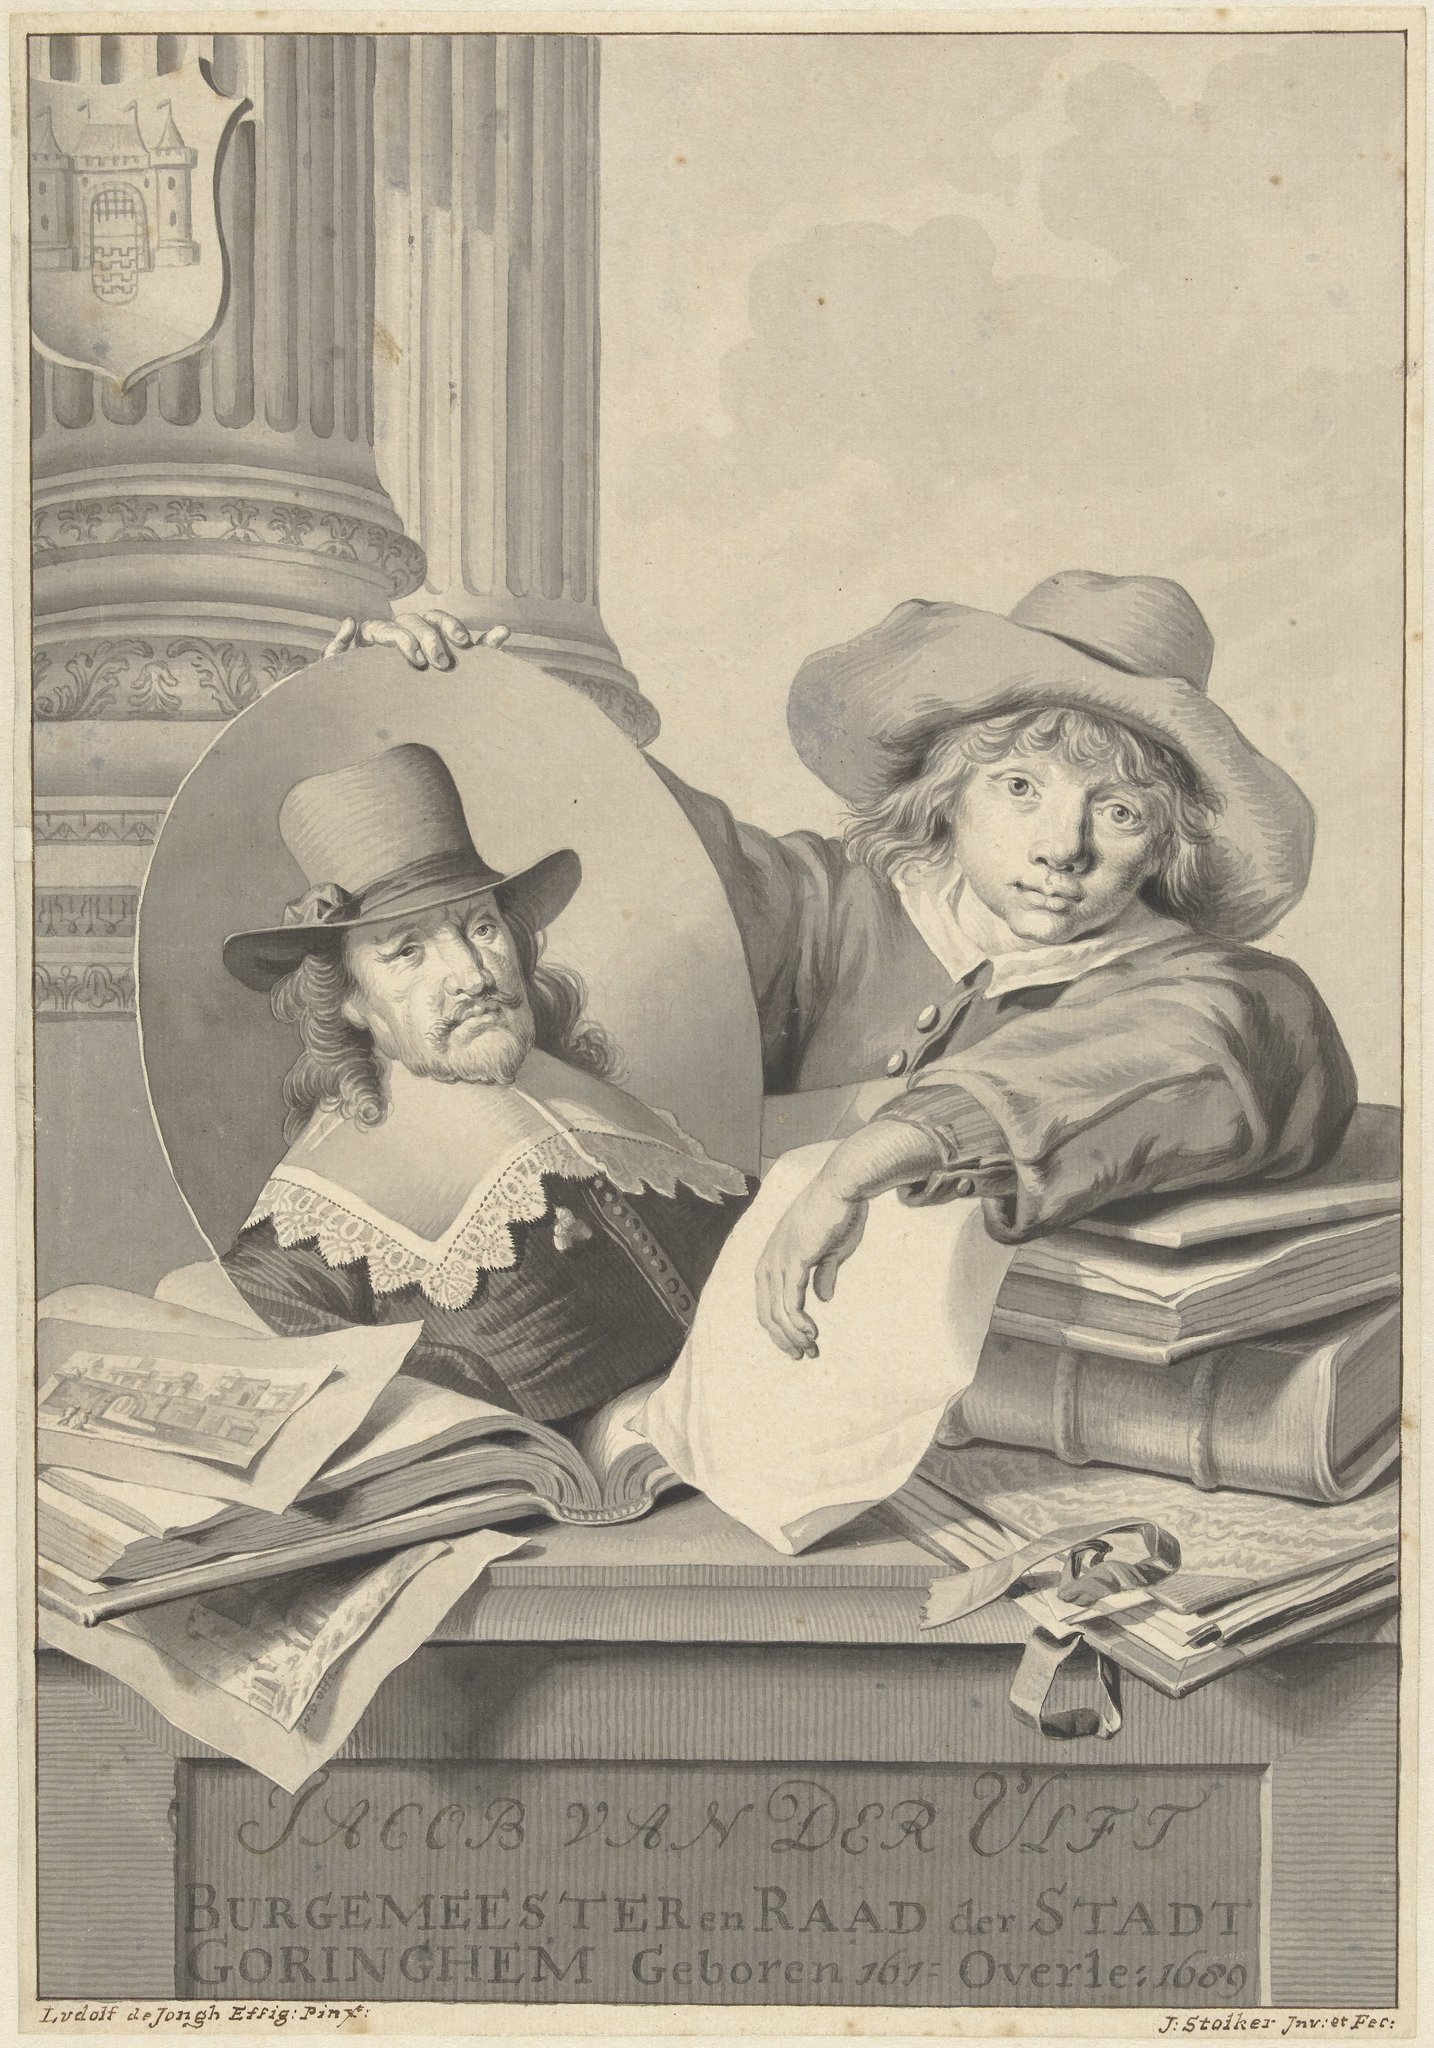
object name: drawing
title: Portret van Jacob van der Ulft, vastgehouden door een jongen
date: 1734-1785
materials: ink, paper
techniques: brush, pen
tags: painter, print maker, draughtsman, jacob van der ulft, historical persons, picture within picture, portrait, self-portrait of artist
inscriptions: inscription: ‘Jacob van der Ulft / BURGEMEESTER en RAAD der STADT / GORINGHEM Geboren 161= Overle: 1689’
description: Portret van Jacob van der Ulft, vastgehouden door een jongen, leunend op boeken en mappen met tekeningen.